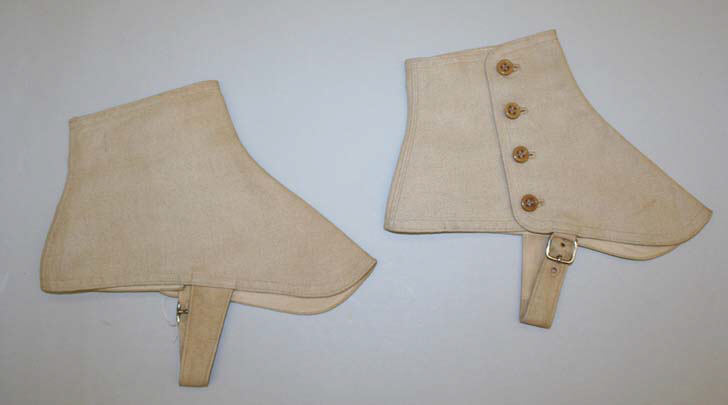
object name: spat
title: Spats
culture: american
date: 1867-1900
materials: linen